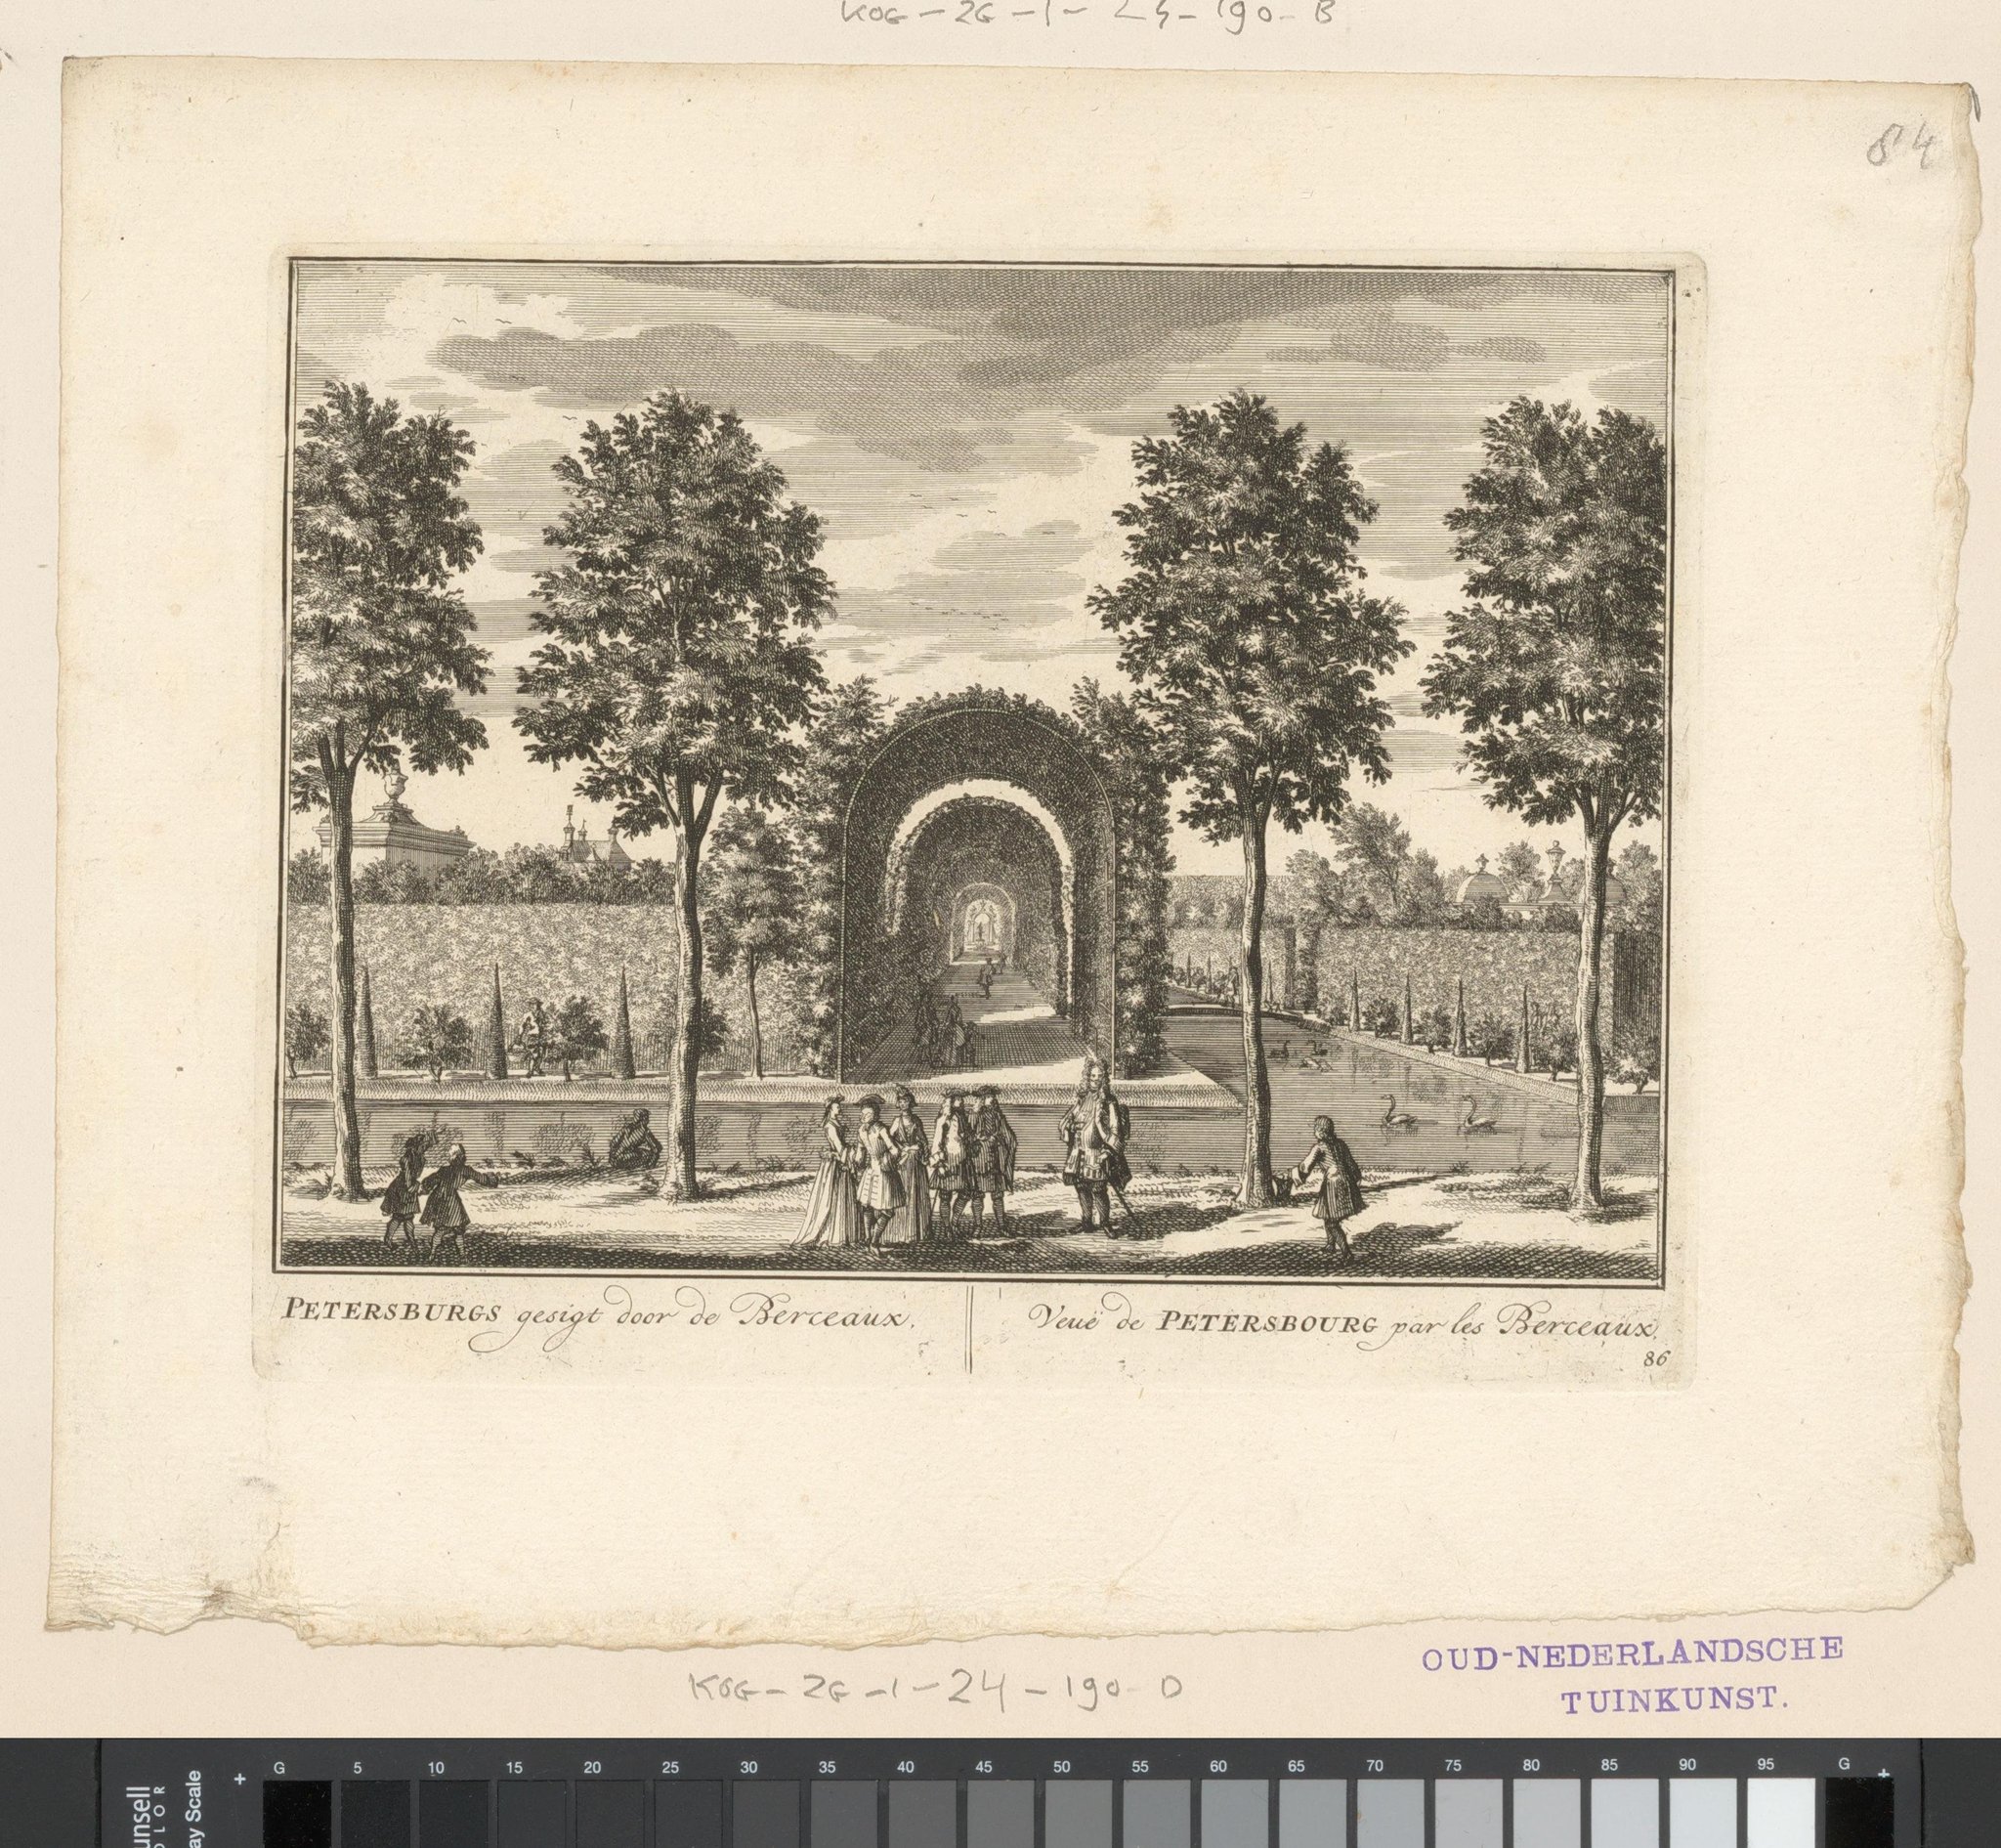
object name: print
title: Petersburgs gesigt door de Berceaux / Veuë de Petersbourg par les Berceaux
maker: hendrik de leth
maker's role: draughtsman, print maker, publisher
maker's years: 1703-1766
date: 1729-1732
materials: paper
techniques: engraving, etching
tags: french or architectonic garden; formal garden, pergola, country-house, nederhorst den berg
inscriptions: stamp, stamp, collector's mark: Lugt 1641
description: Prent mogelijk uit: Brouërius van Nidek, Matthaeus. Het zegepralend Kennemerland, vertoond in 100 heerlyke gezichten. Amsterdam: Jan Roman, s.a. Of uit: Brouërius van Nidek, Matthaeus. Het zegepralend Kennemerland, vertoond in veele heerlyke gezichten. Amsterdam: Andries en Hendrik de Leth, s.a [1729-1732]. Of uit: Brouërius van Nidek, Matthaeus. Het zegepralend Kennemerland, vertoond in veele heerlyke gezichten. Amsterdam: Jan Roman, s.a.